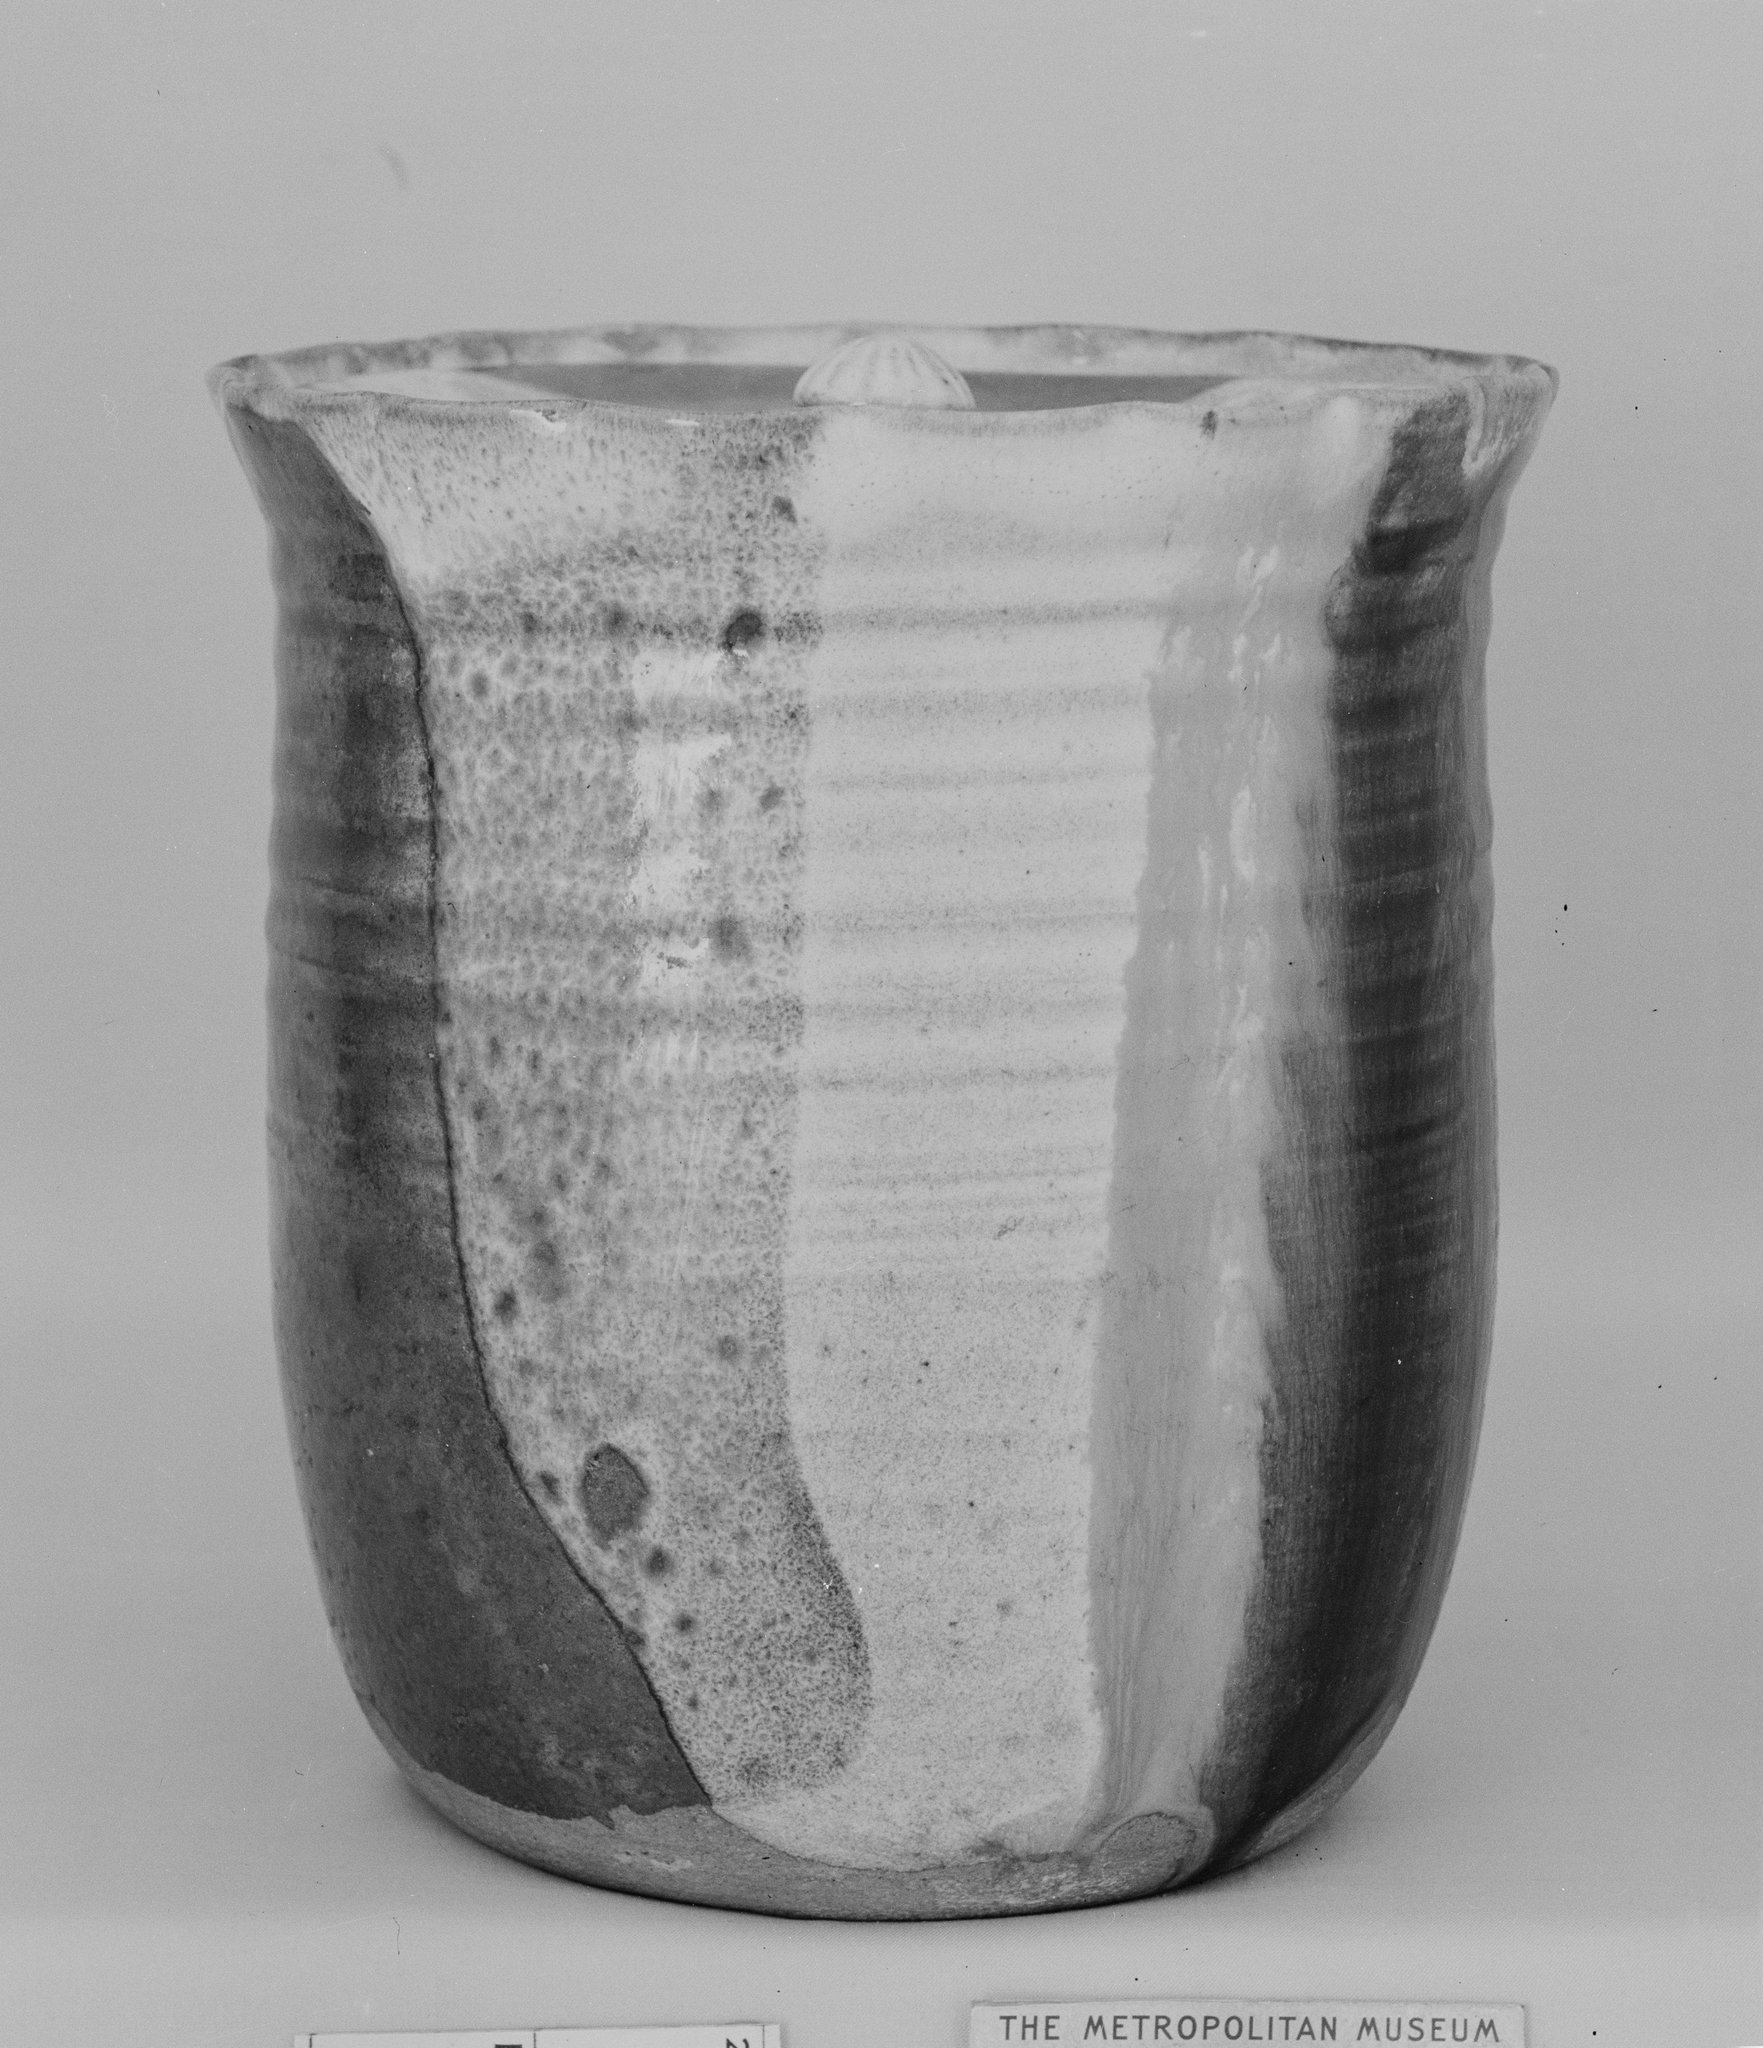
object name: water pot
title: Water Pot with Lid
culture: japanese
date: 1801-1900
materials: clay, glaze, pottery